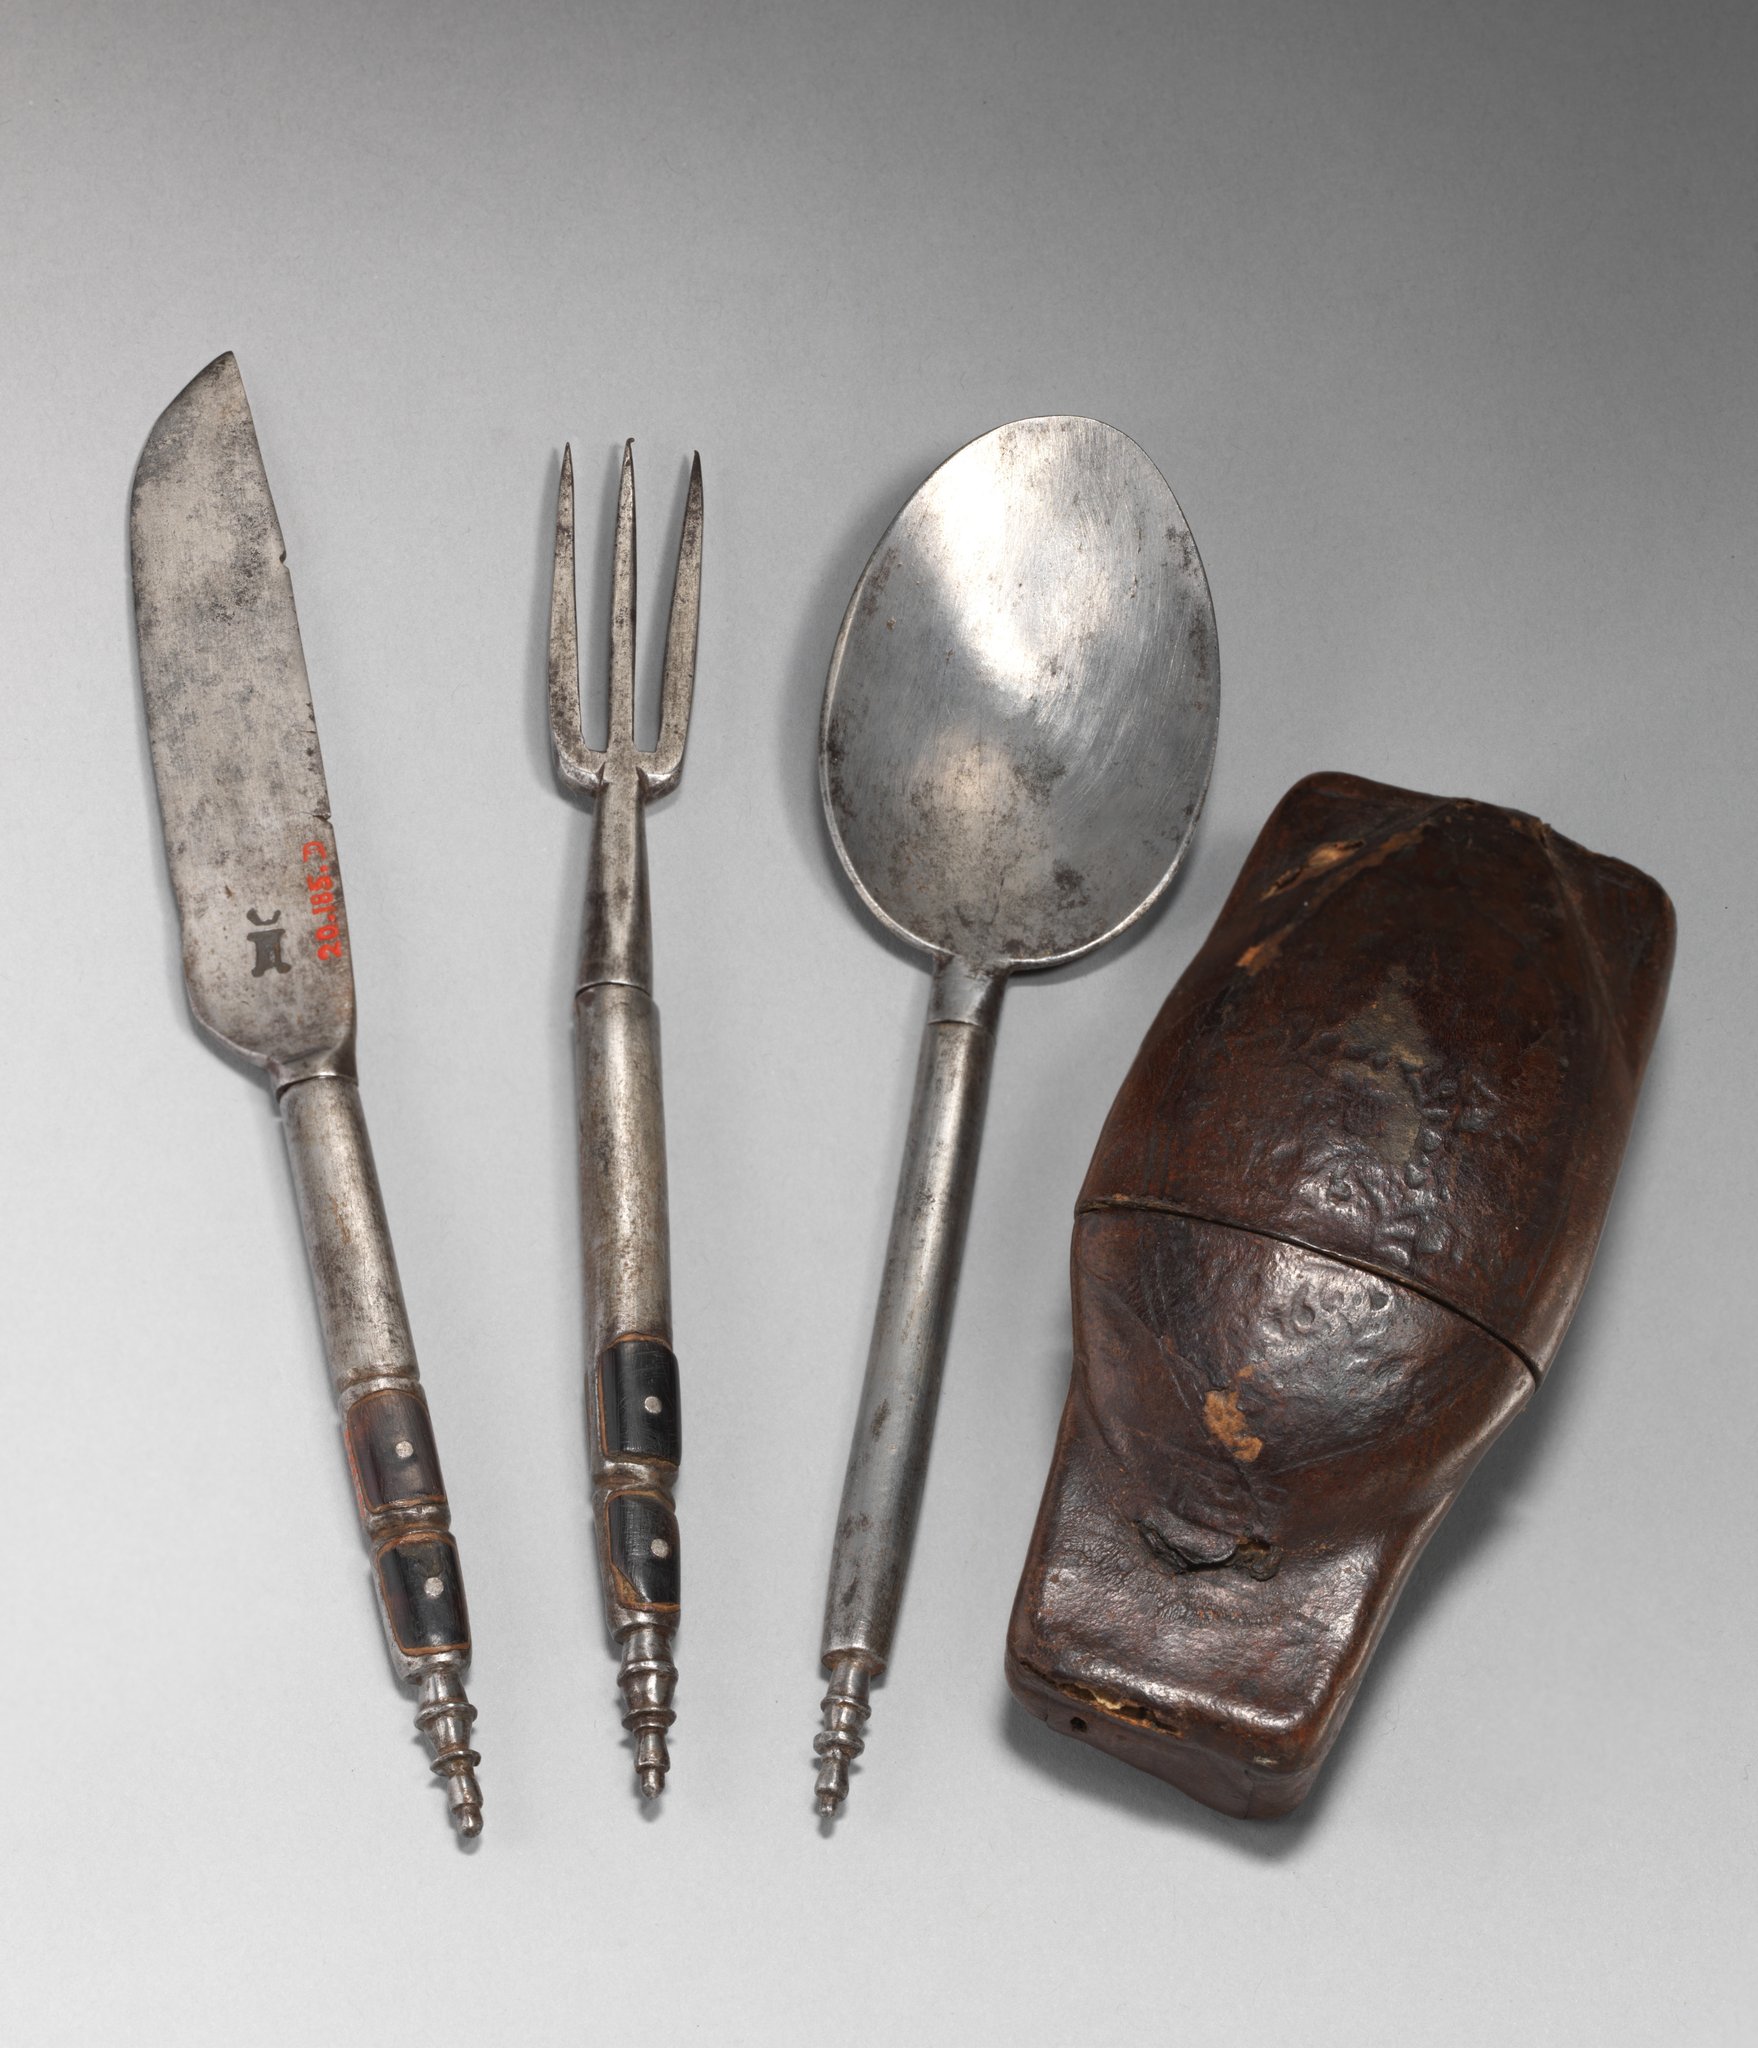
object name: knife, fork, and spoon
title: Knife, fork, and spoon in traveling case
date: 1601-1700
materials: leather, steel, shell